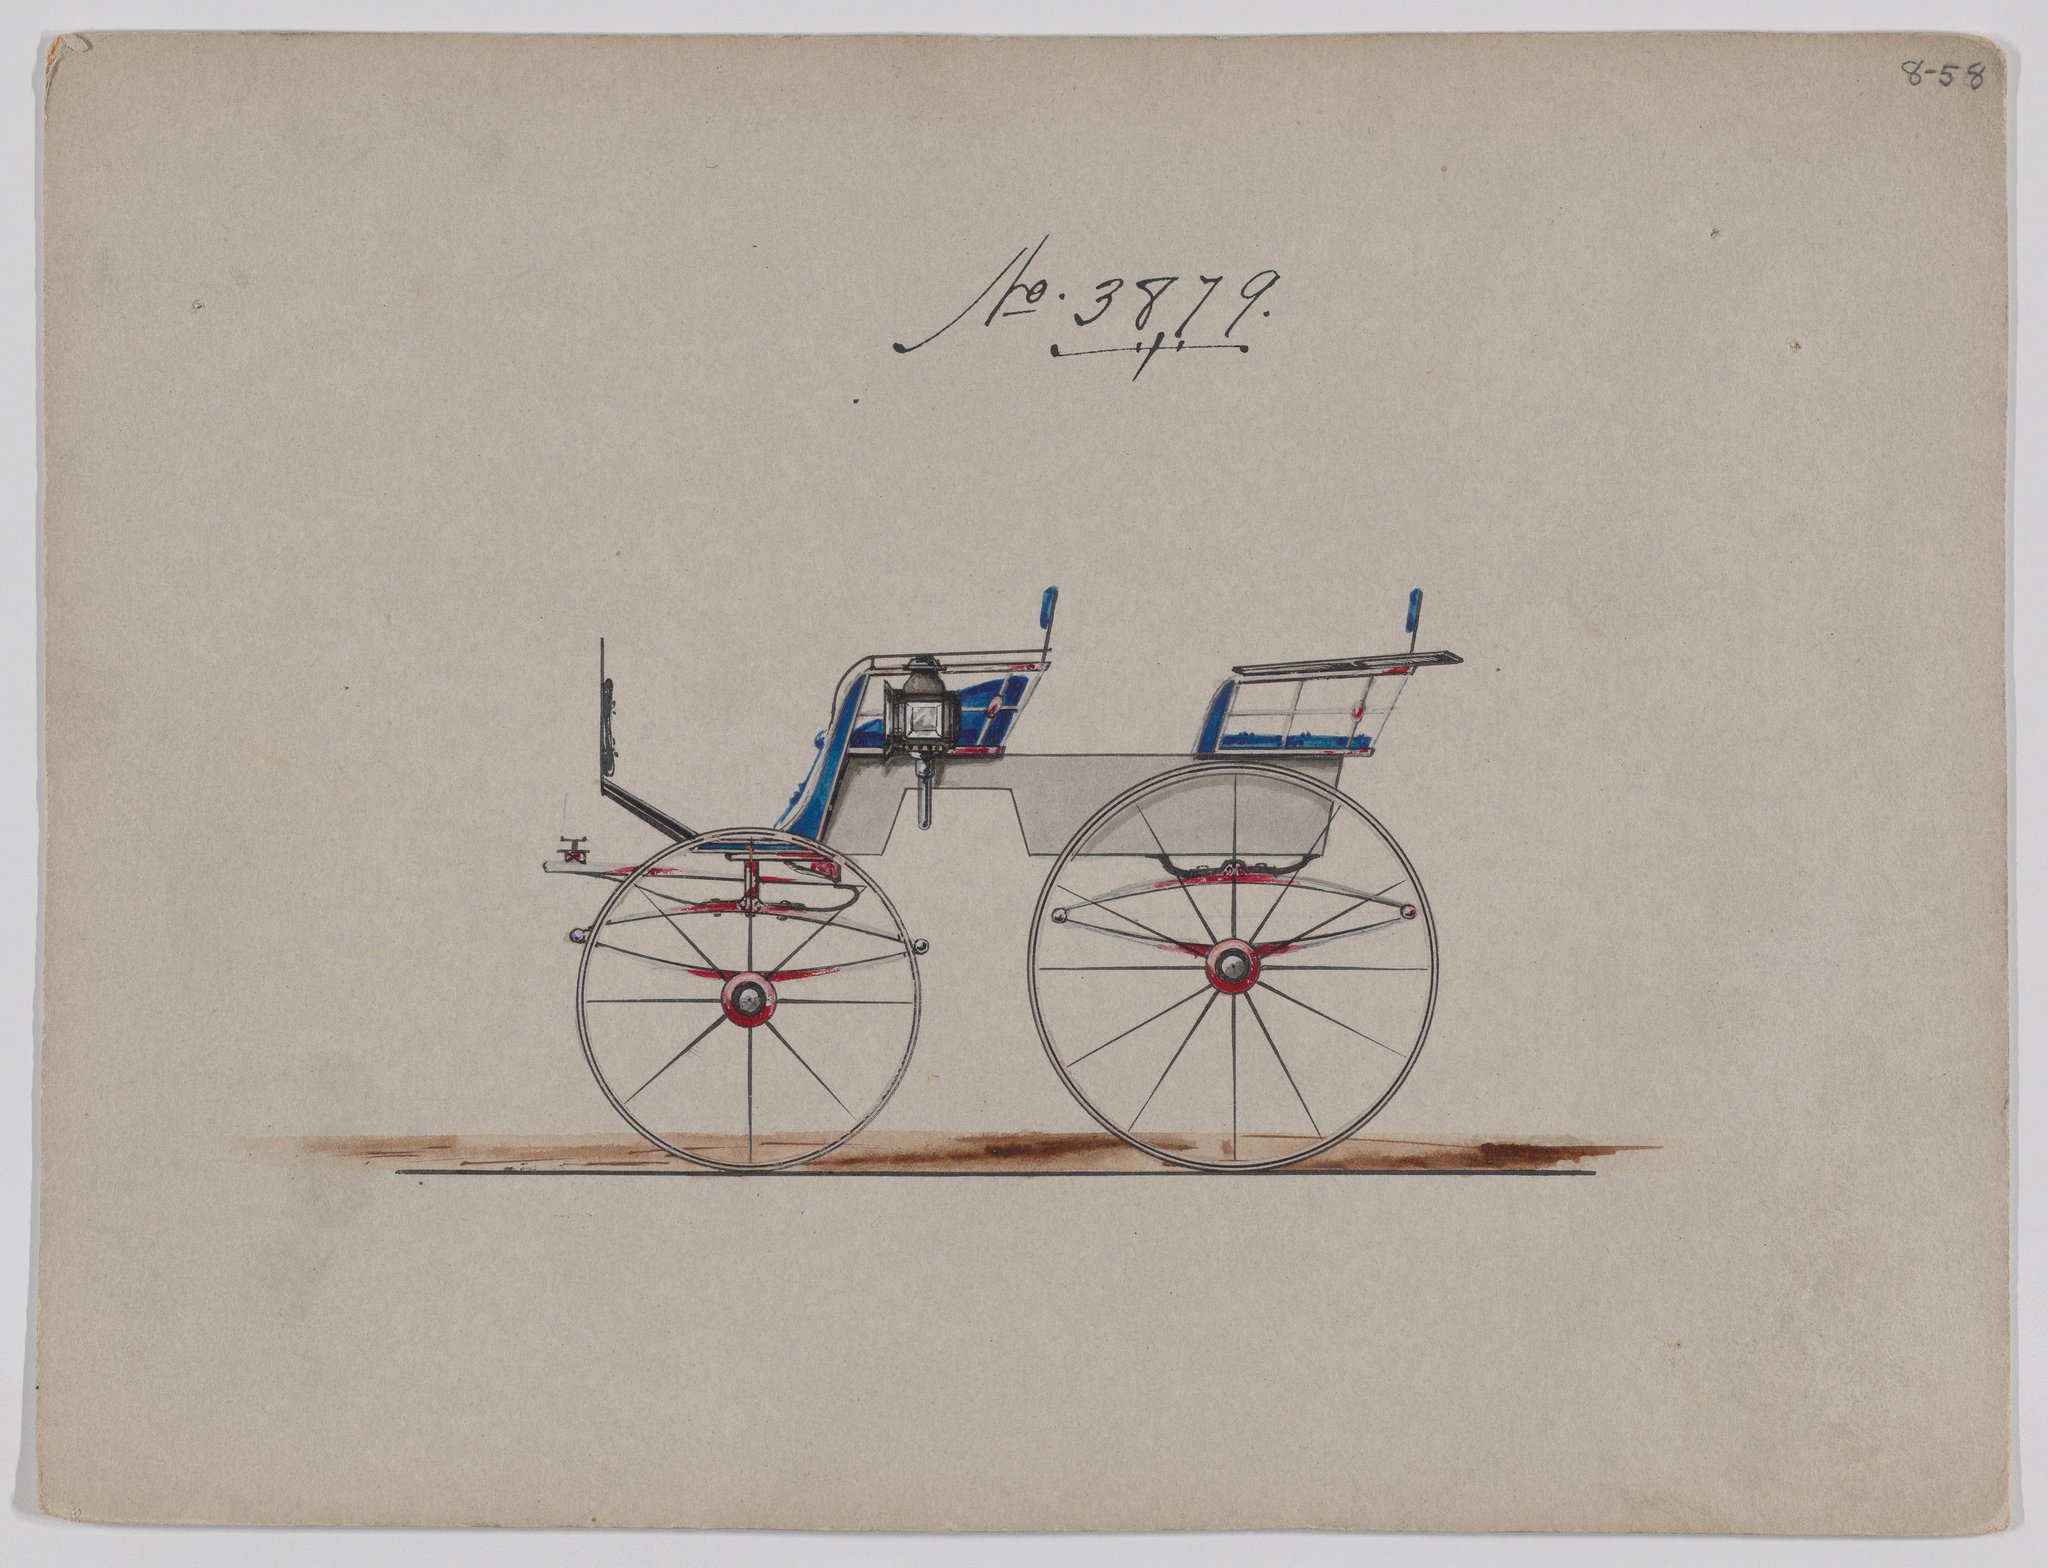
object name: drawing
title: Design for 4 seat Phaeton, no top, no. 3879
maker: brewster & co.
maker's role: manufacturer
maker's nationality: american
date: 1884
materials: gouache, gum arabic, ink, watercolor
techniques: pen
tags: carriages